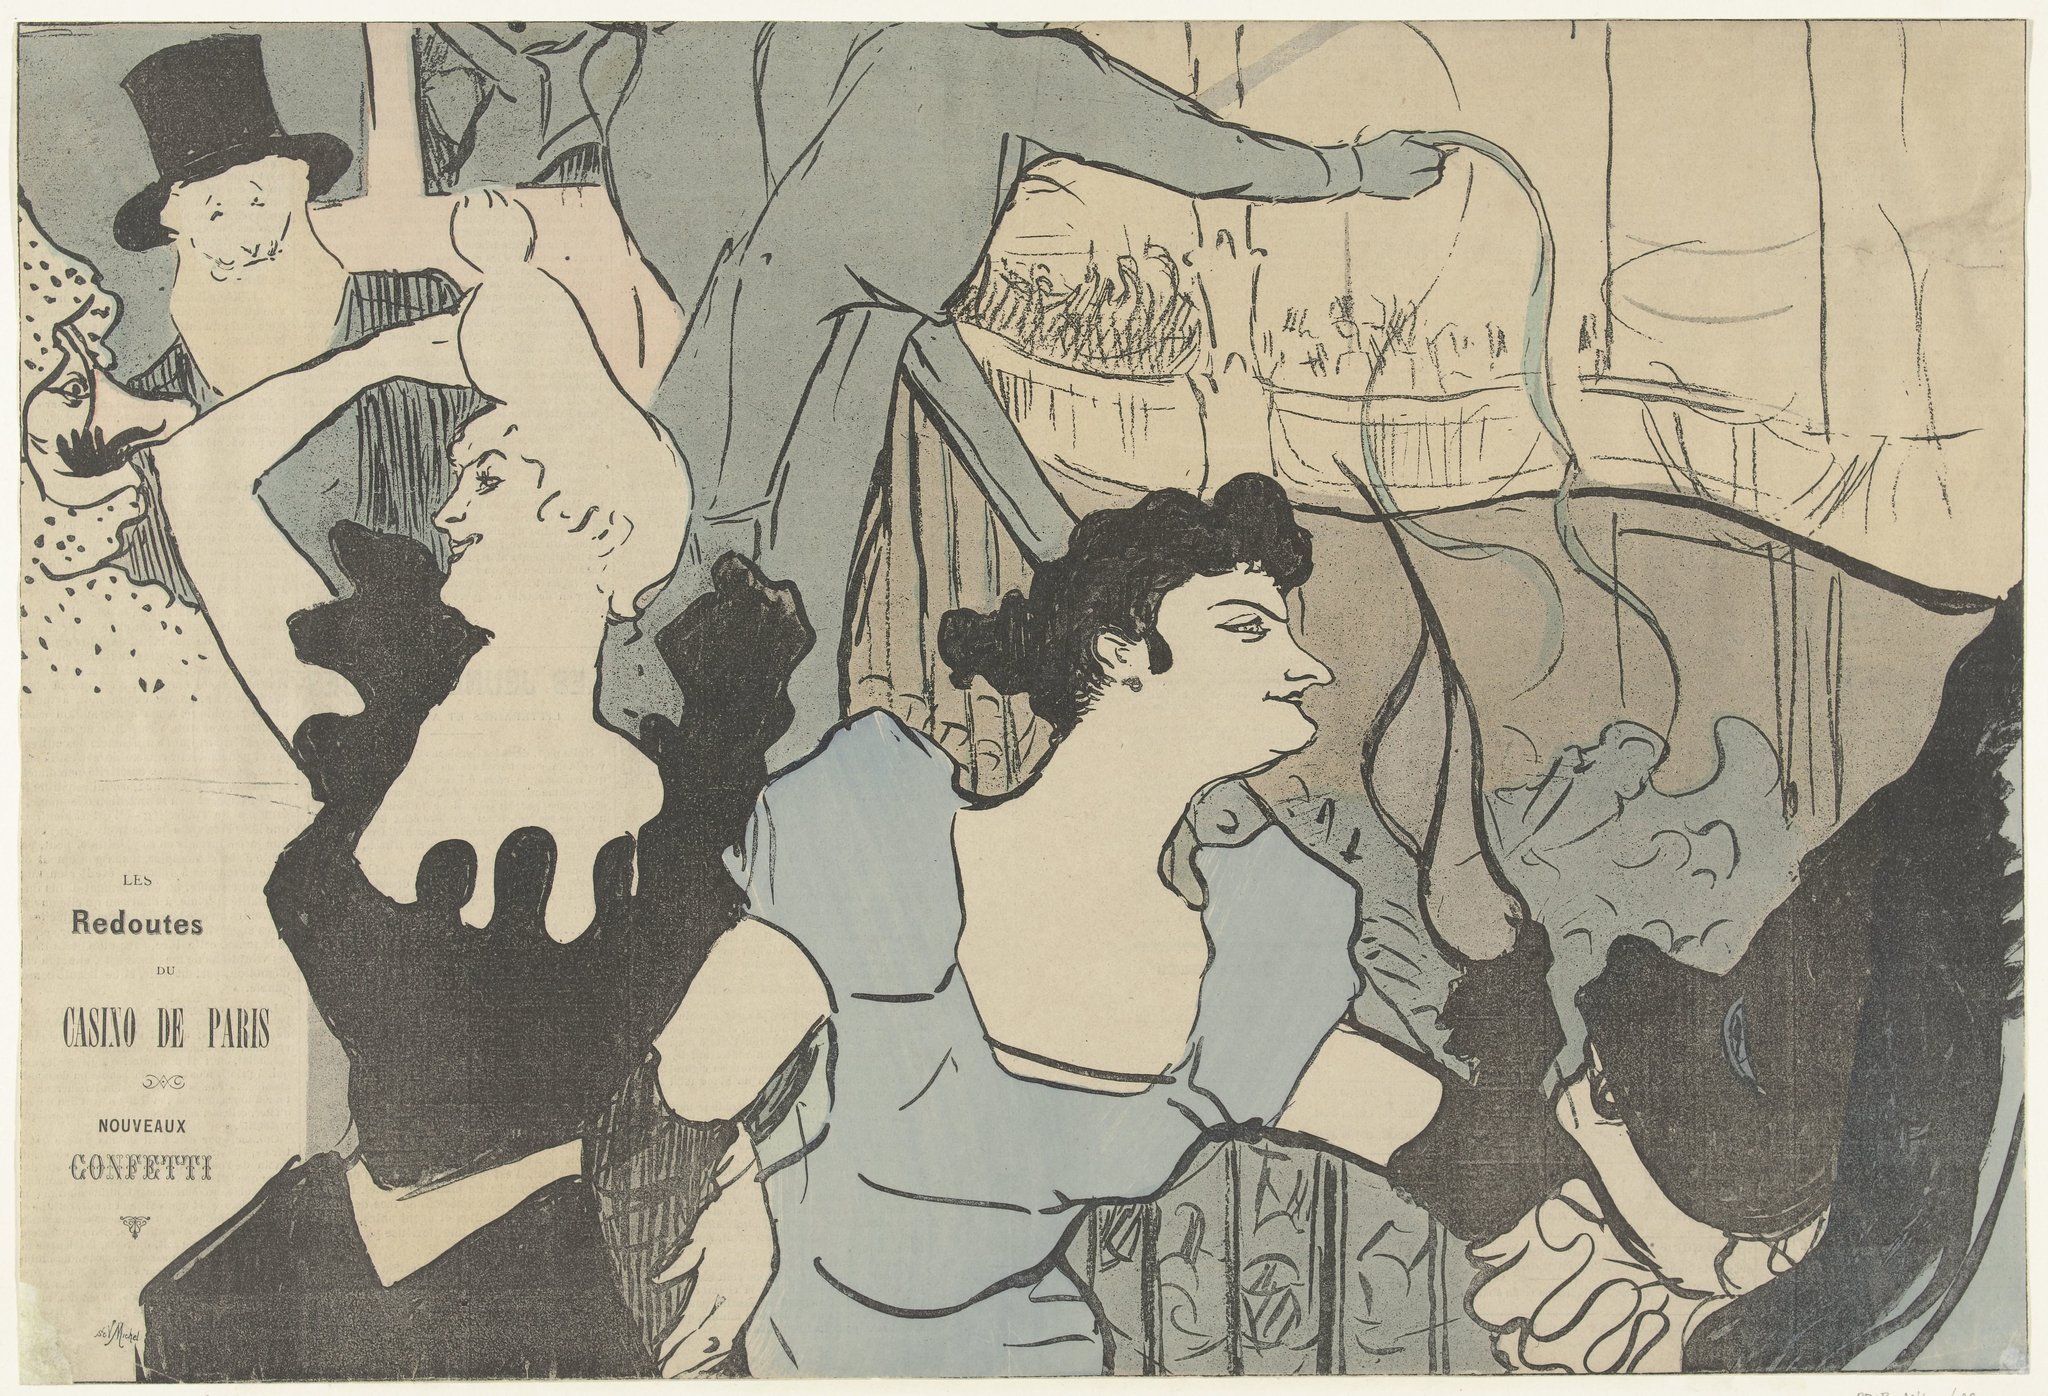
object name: print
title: Les Redoutes du Casino de Paris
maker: v. michel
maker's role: print maker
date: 1892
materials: paper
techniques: printing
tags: masquerade, masked ball, paris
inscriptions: collector's mark: Lugt 2760, collector's mark: Lugt 2228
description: Affiche met aankondiging van gemaskerd bal in Casino van Parijs met verschillende deelnemers aan het feest. Op de voorgrond staan twee vrouwen, links de clown Cha-u-kao en rechts actrice Yvette Guilbert. Linksachter zijn twee portretten van mannen weergegeven: de man met hoed is Alphonse Toulouse-Lautrec en het grote hoofd met confetti is een zelfportret van de kunstenaar. Linksonder staat de tekst Les redoutes du Casino de Paris nouveau confetti.